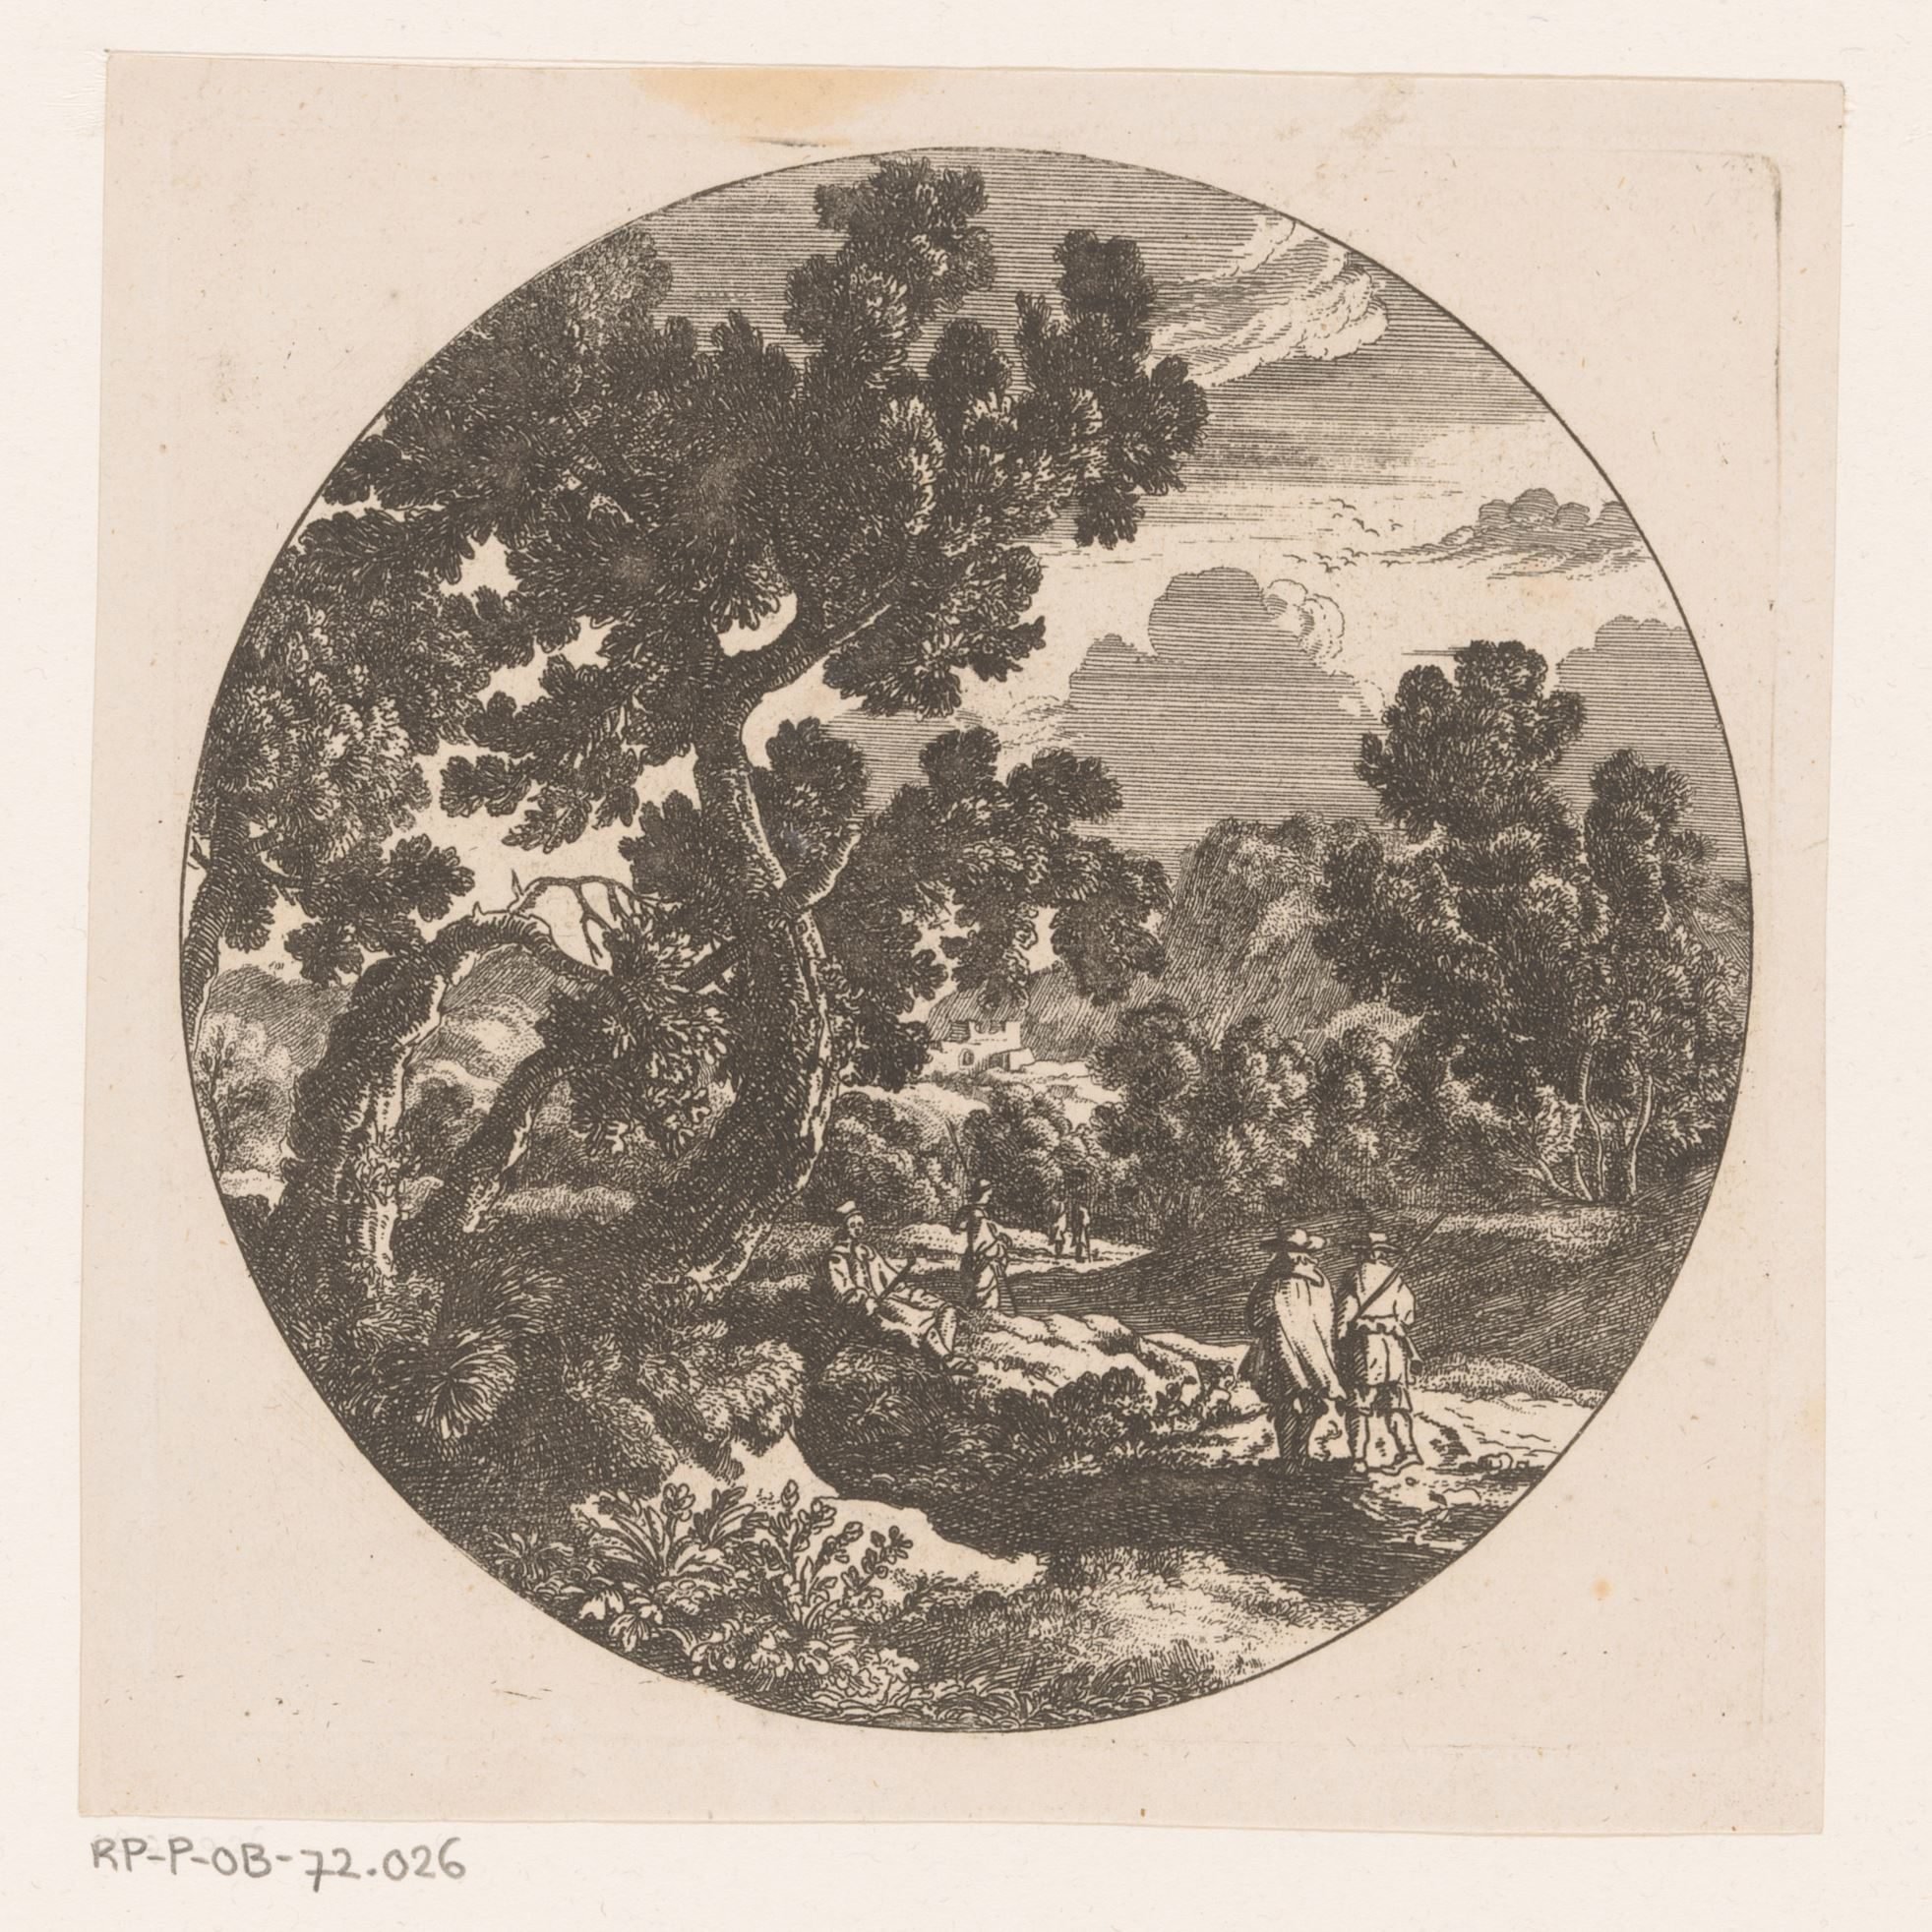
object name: print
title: Boslandschap met figuren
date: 1613-1695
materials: paper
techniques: etching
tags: landscapes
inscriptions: collector's mark: Lugt 2228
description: Prenten met het signatuur 'Perelle' kunnen zowel door vader Gabriel als door zonen Nicolas en Adam gemaakt zijn.